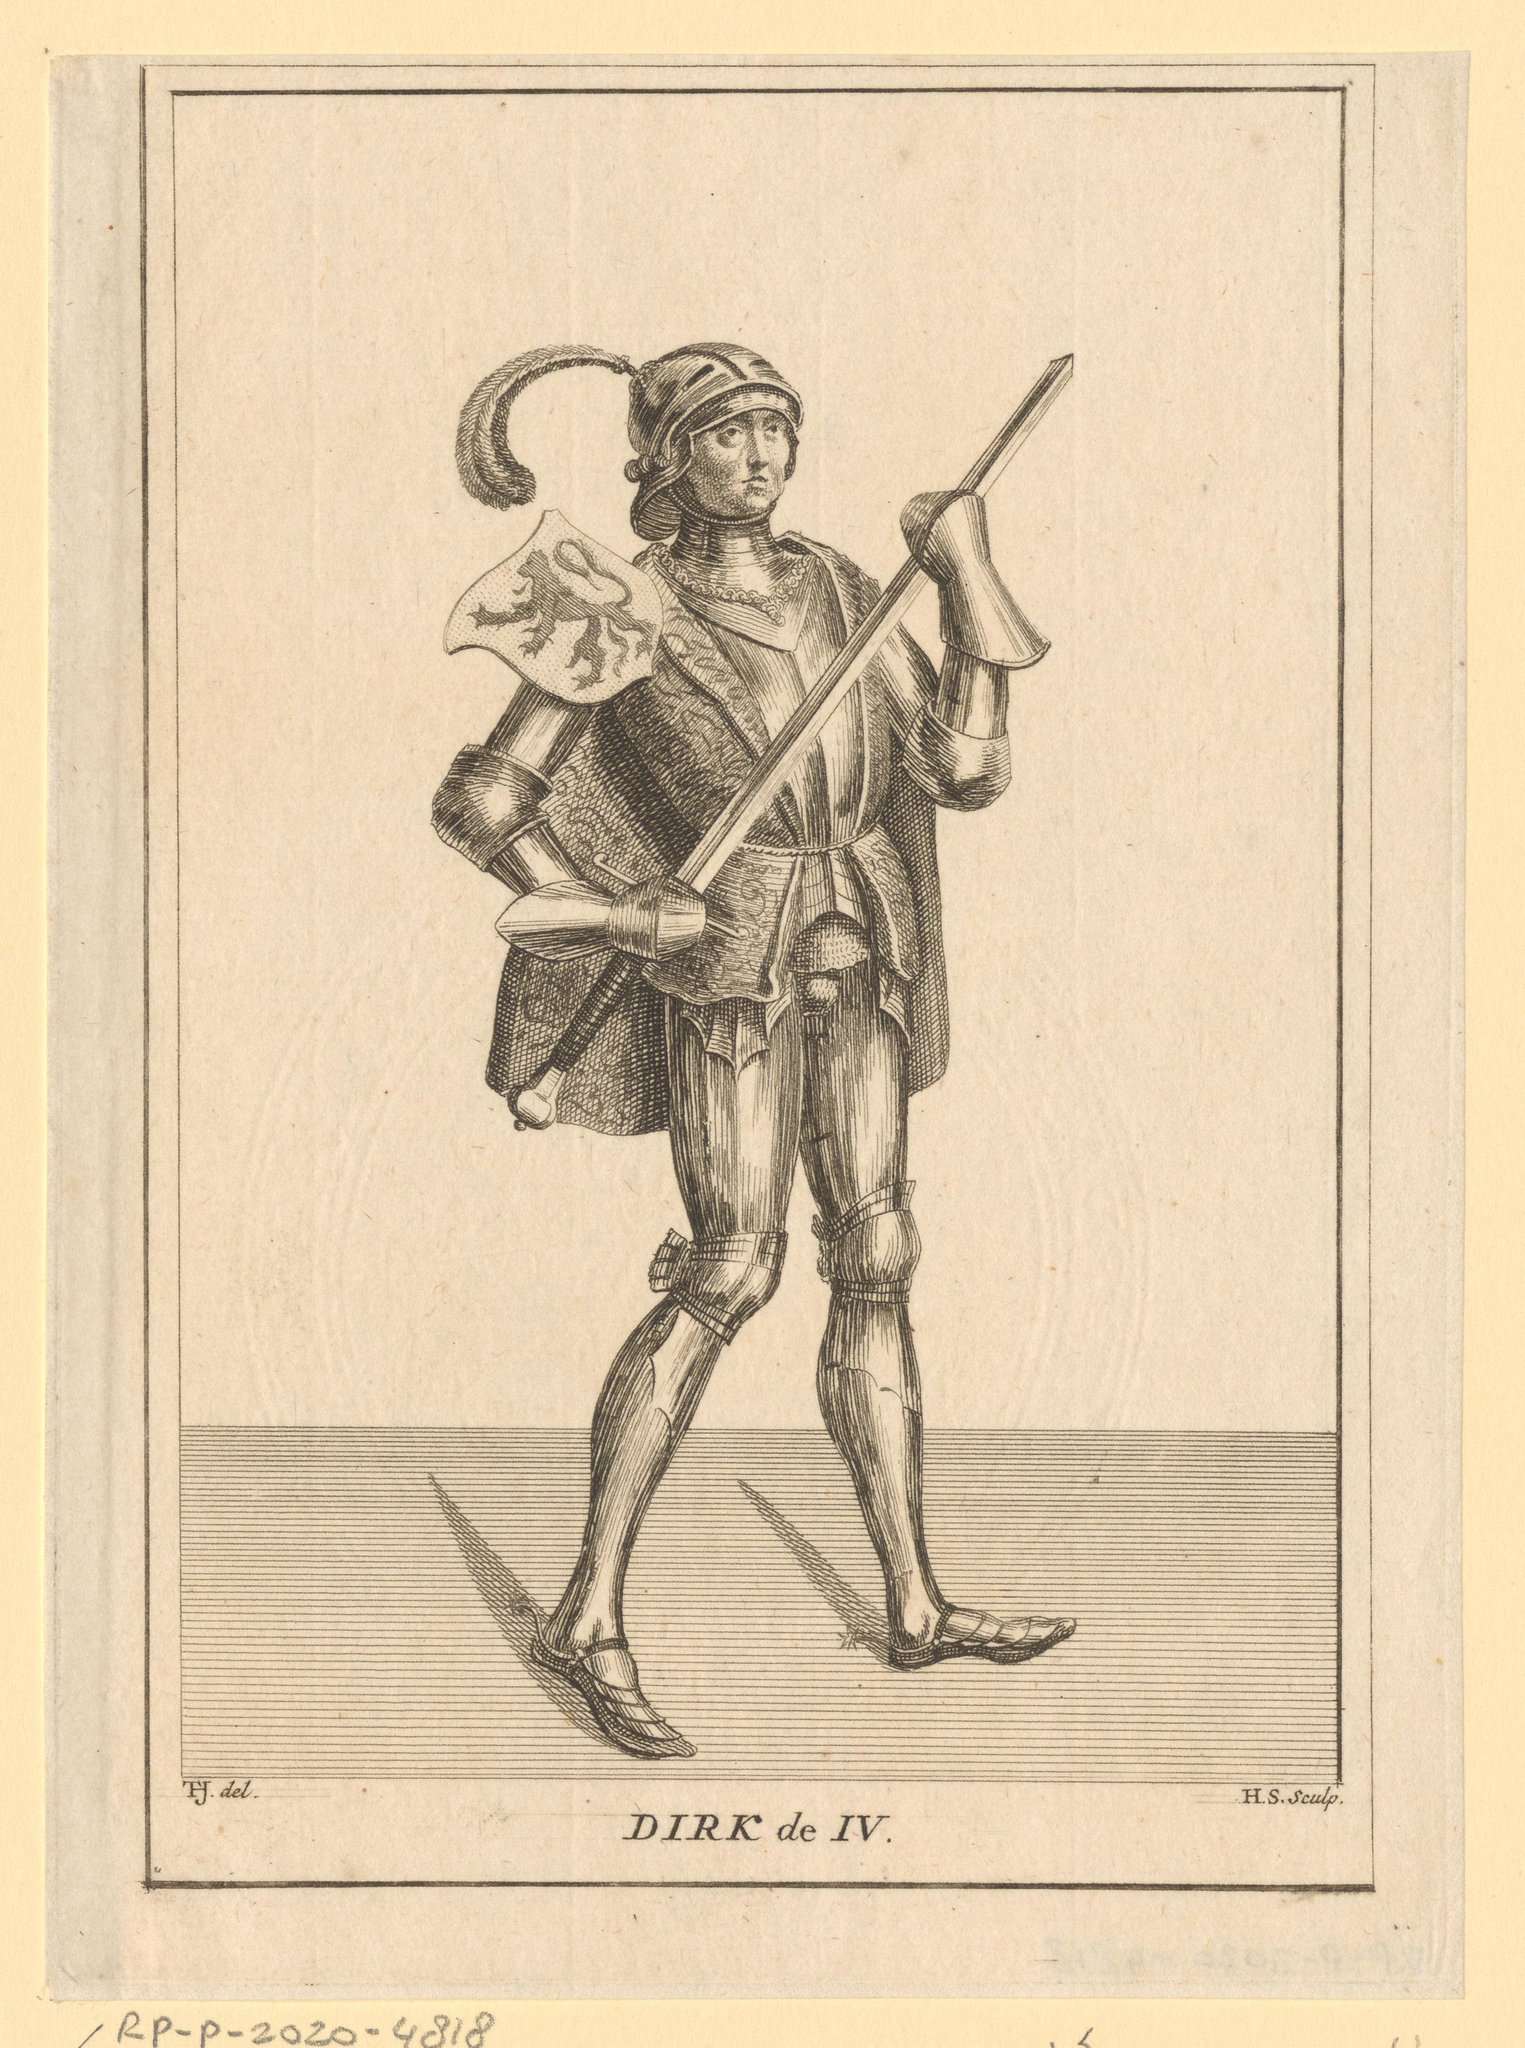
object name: print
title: Portret van Dirk IV, graaf van Holland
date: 1745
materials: paper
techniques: etching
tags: historical persons, hacking and thrusting weapons: sword, ruler, sovereign, armorial bearing, heraldry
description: Prent waarschijnlijk uit: Langendyk, Pieter. De graaven van Holland, in jaardichten beschreven. Haarlem: Jan Bosch, 1745, dl. 1.